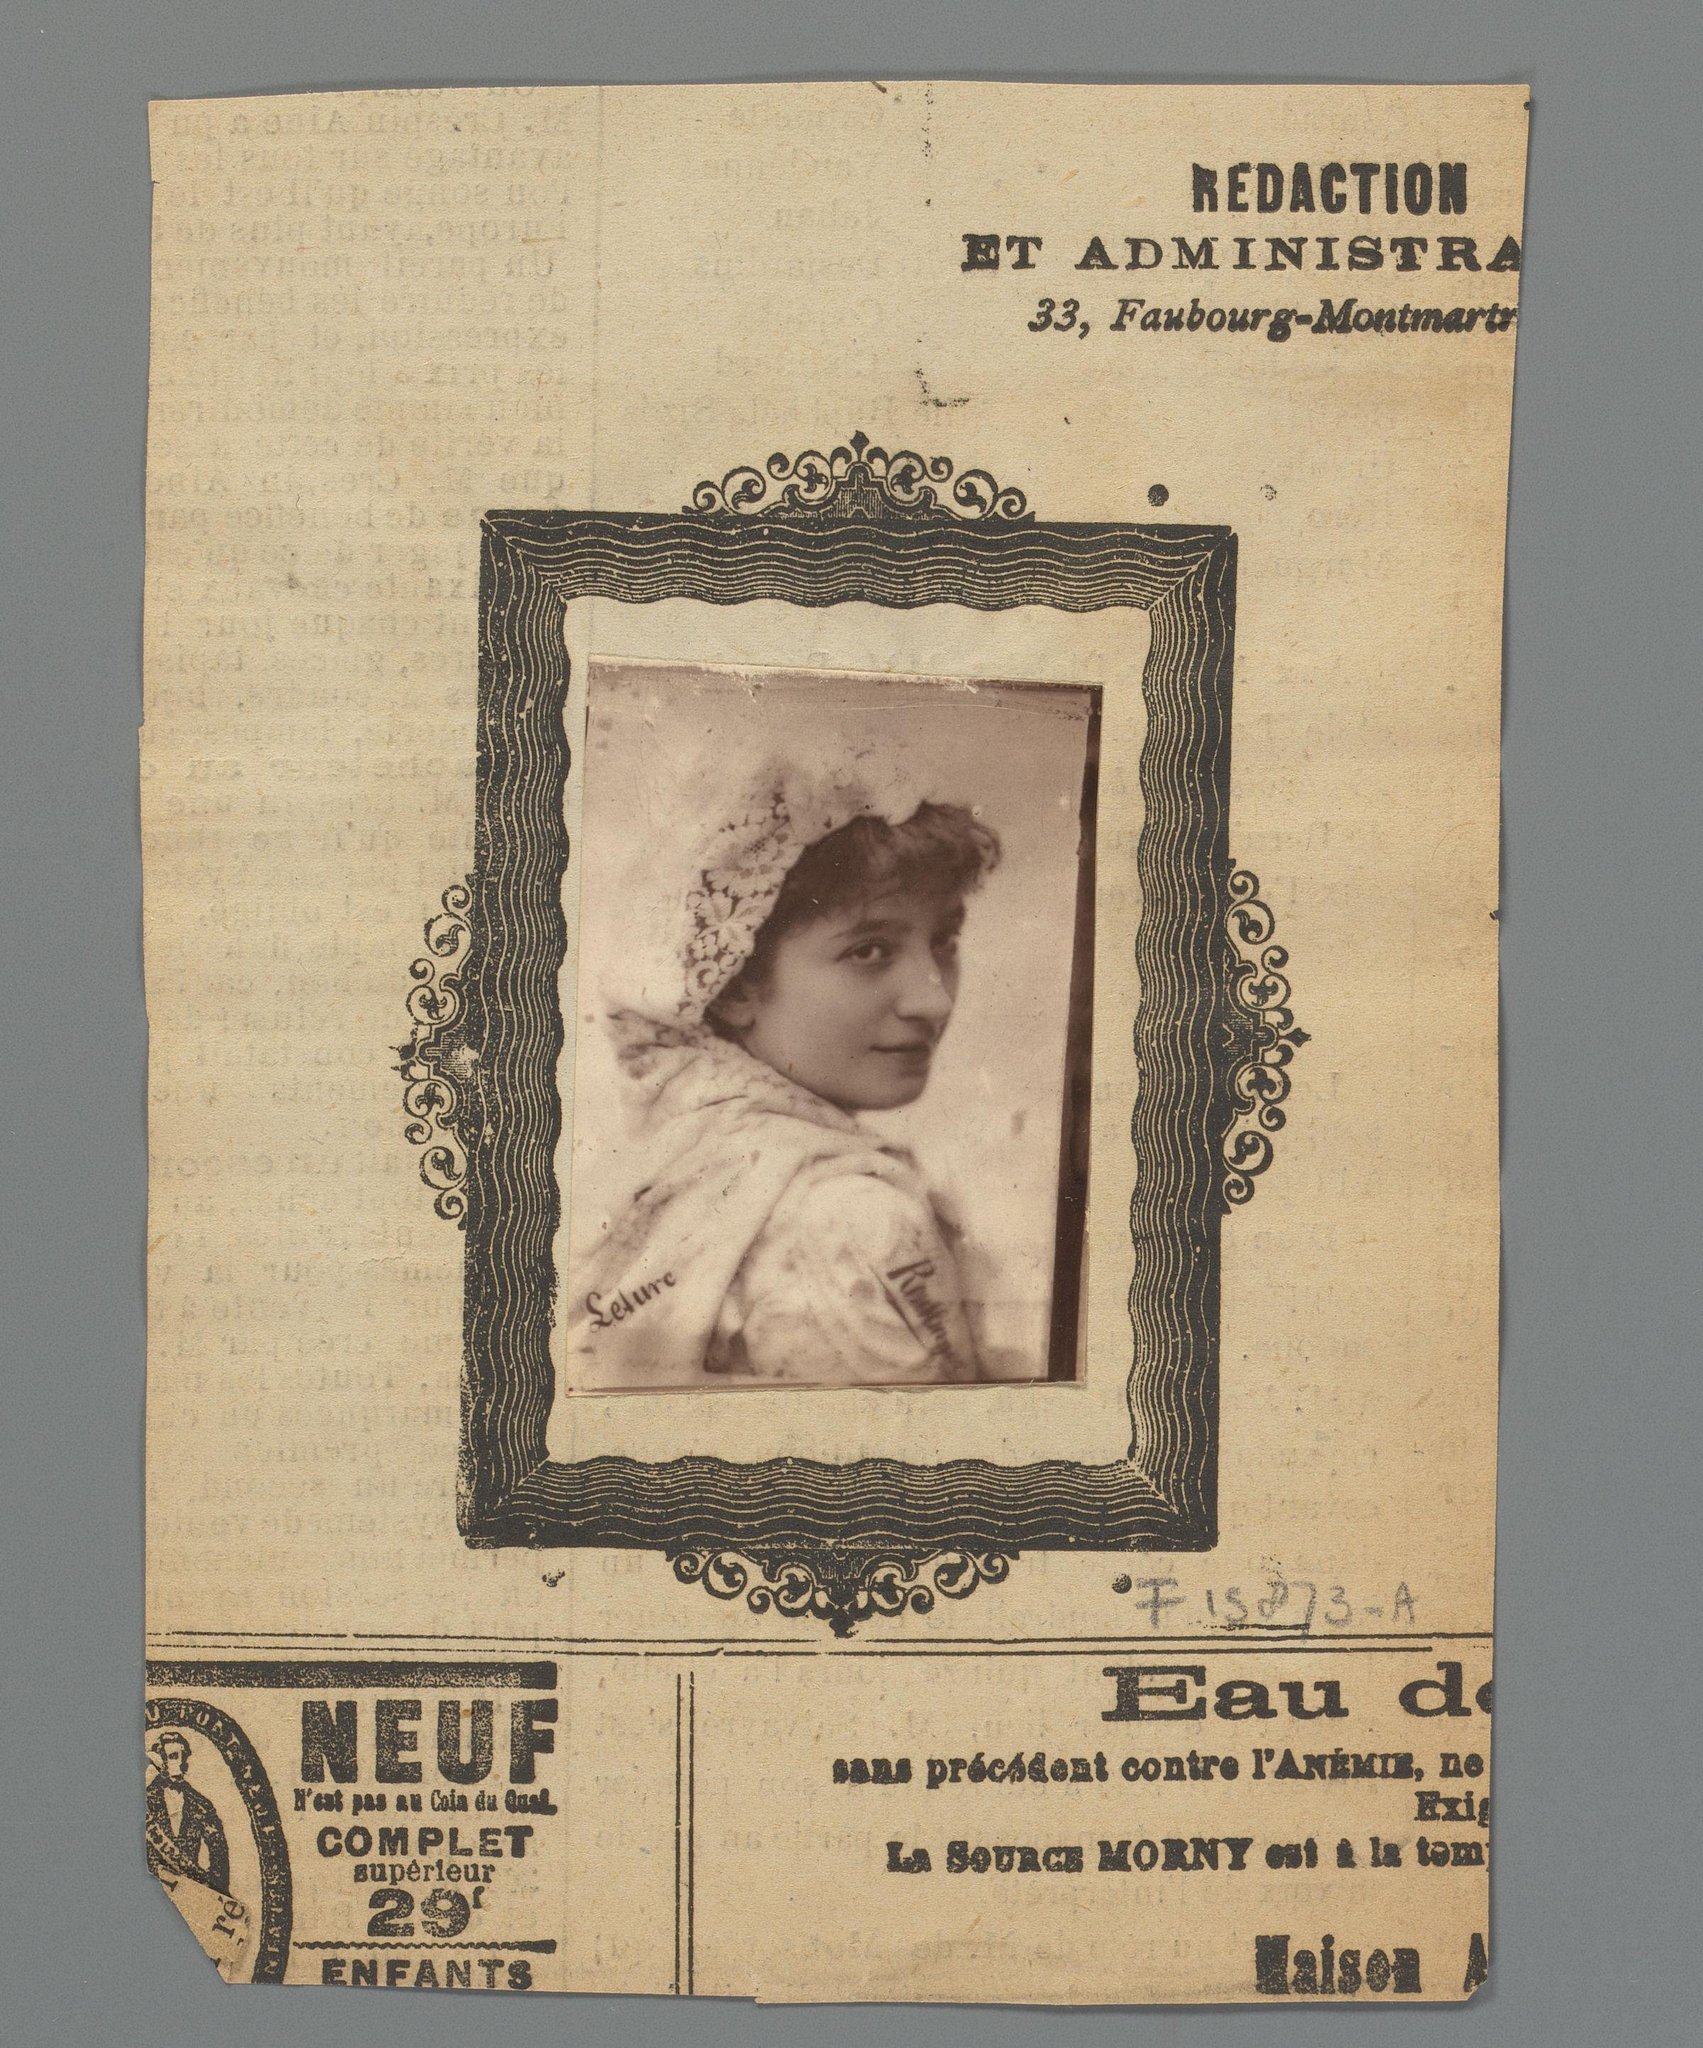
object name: newspaper clipping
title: Portret van een onbekende actrice, aangeduid als Leture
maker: charles reutlinger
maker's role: publisher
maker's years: 1816-1880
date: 1890-1910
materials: paper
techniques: albumen print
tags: portrait of actor, actress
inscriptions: inscription: ‘Leture/ Reutlinger’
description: Knipsel uit 'Les Folies-Bergèr, journal spécial au théâtre' met een opgeplakt fotoportret.